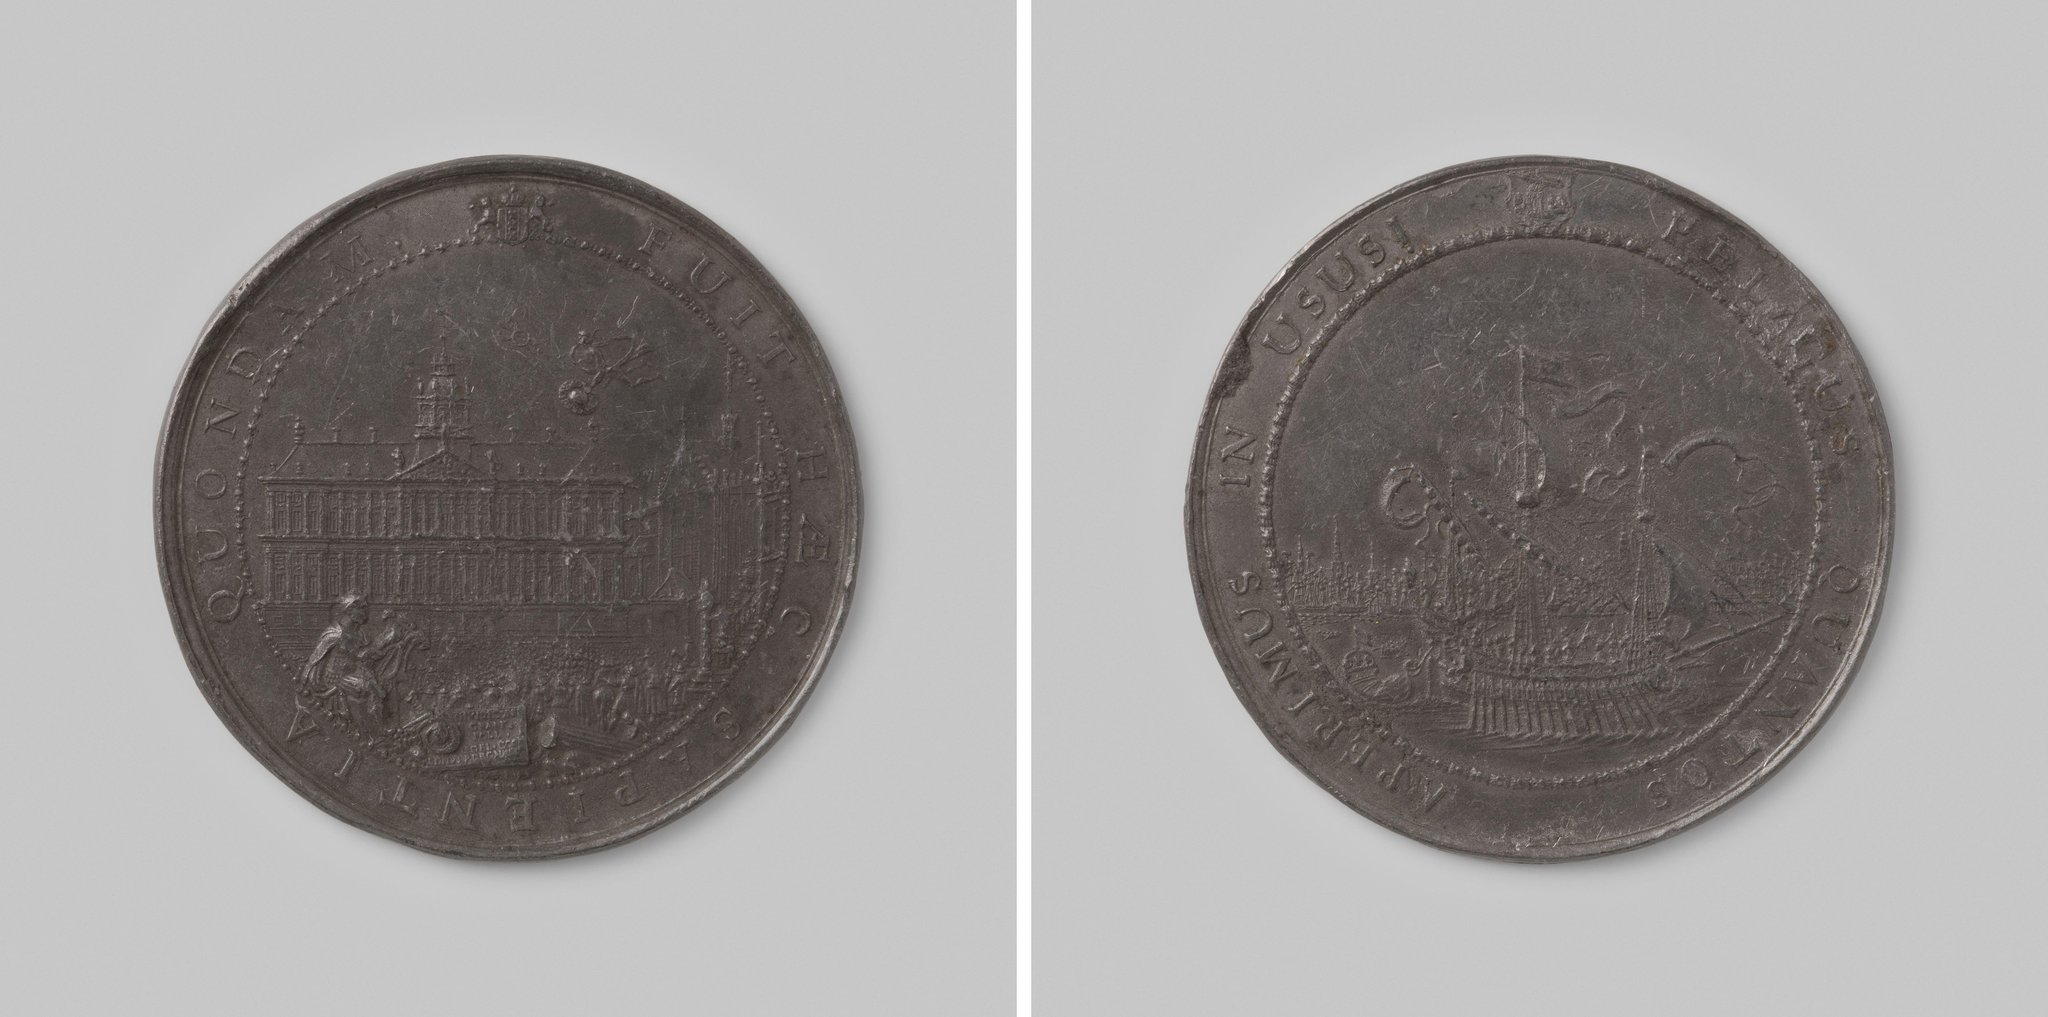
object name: history medal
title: Inwijding van het nieuwe stadhuis van Amsterdam 1655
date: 1655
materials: lead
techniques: casting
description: Loden gegoten penning, op de voorzijde het stadhuis waarboven een vliegende Mercurius en op de voorgrond een mensenmassa met op de voorgrond een lierspelende Amfion en een steen met de namen van burgemeesters en schatbewaarders, met omschrift, op de keerzijde een galeischip als Argo met op de achtergrond Amsterdam, met omschrift.